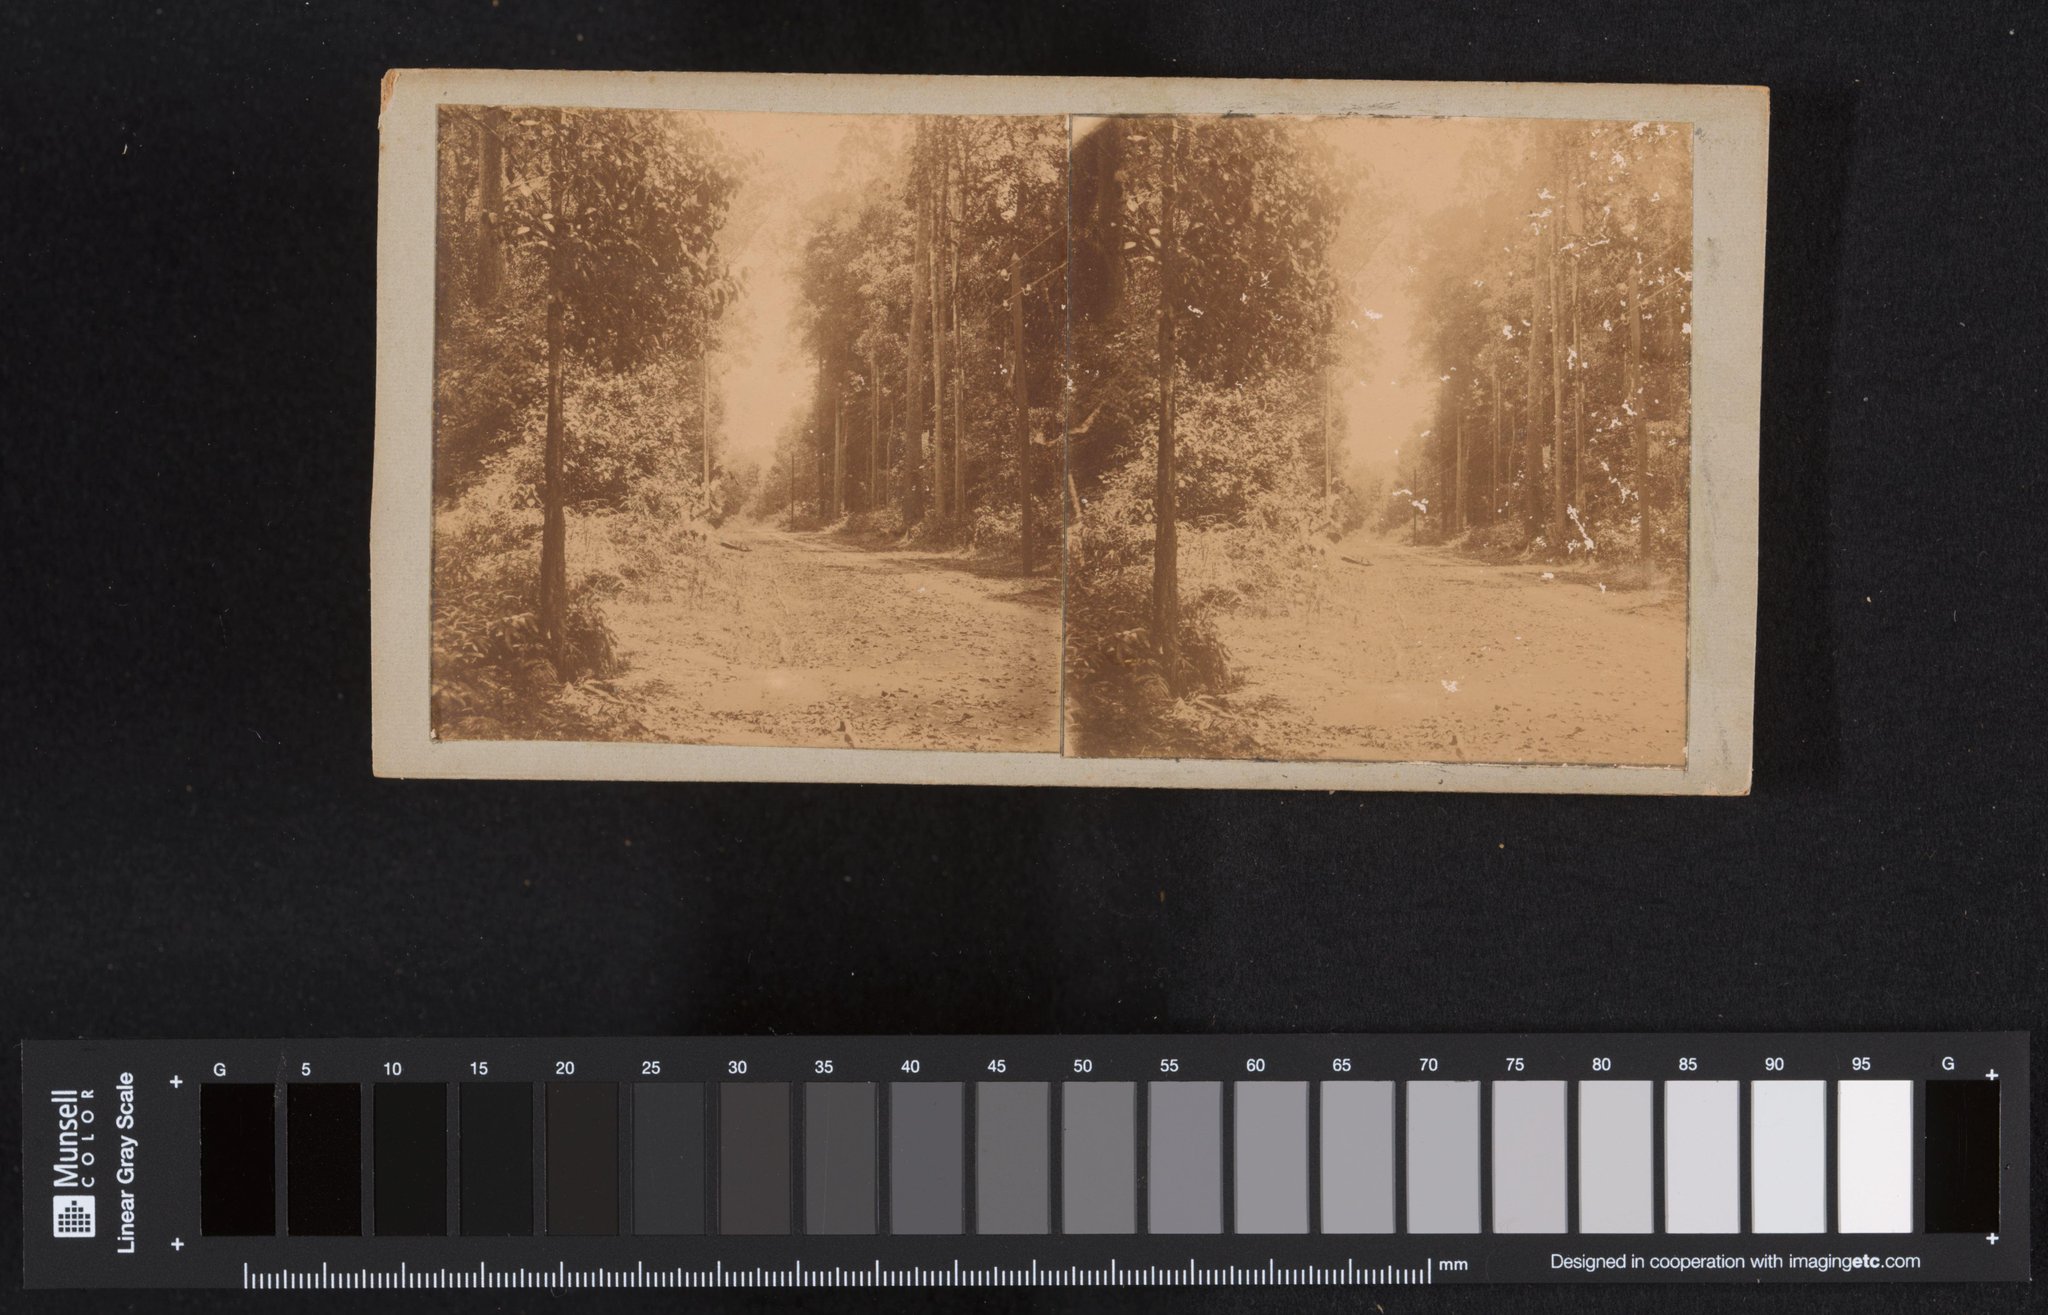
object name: stereograph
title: Weg naar Muntok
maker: robert julius boers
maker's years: 1867-1932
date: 1900-1922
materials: cardboard, photographic support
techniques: gelatin silver print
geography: bangka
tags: robert julius boers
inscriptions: inscription: ‘Simpang Weg naar Muntok’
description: De weg door bos naar Muntok, op Banka. Onderdeel van een groep stereofoto's van Robert Julius Boers, chef van het staatsbedrijf de Banka-tinwinning op Banka, uit de periode ca. 1900-1922.